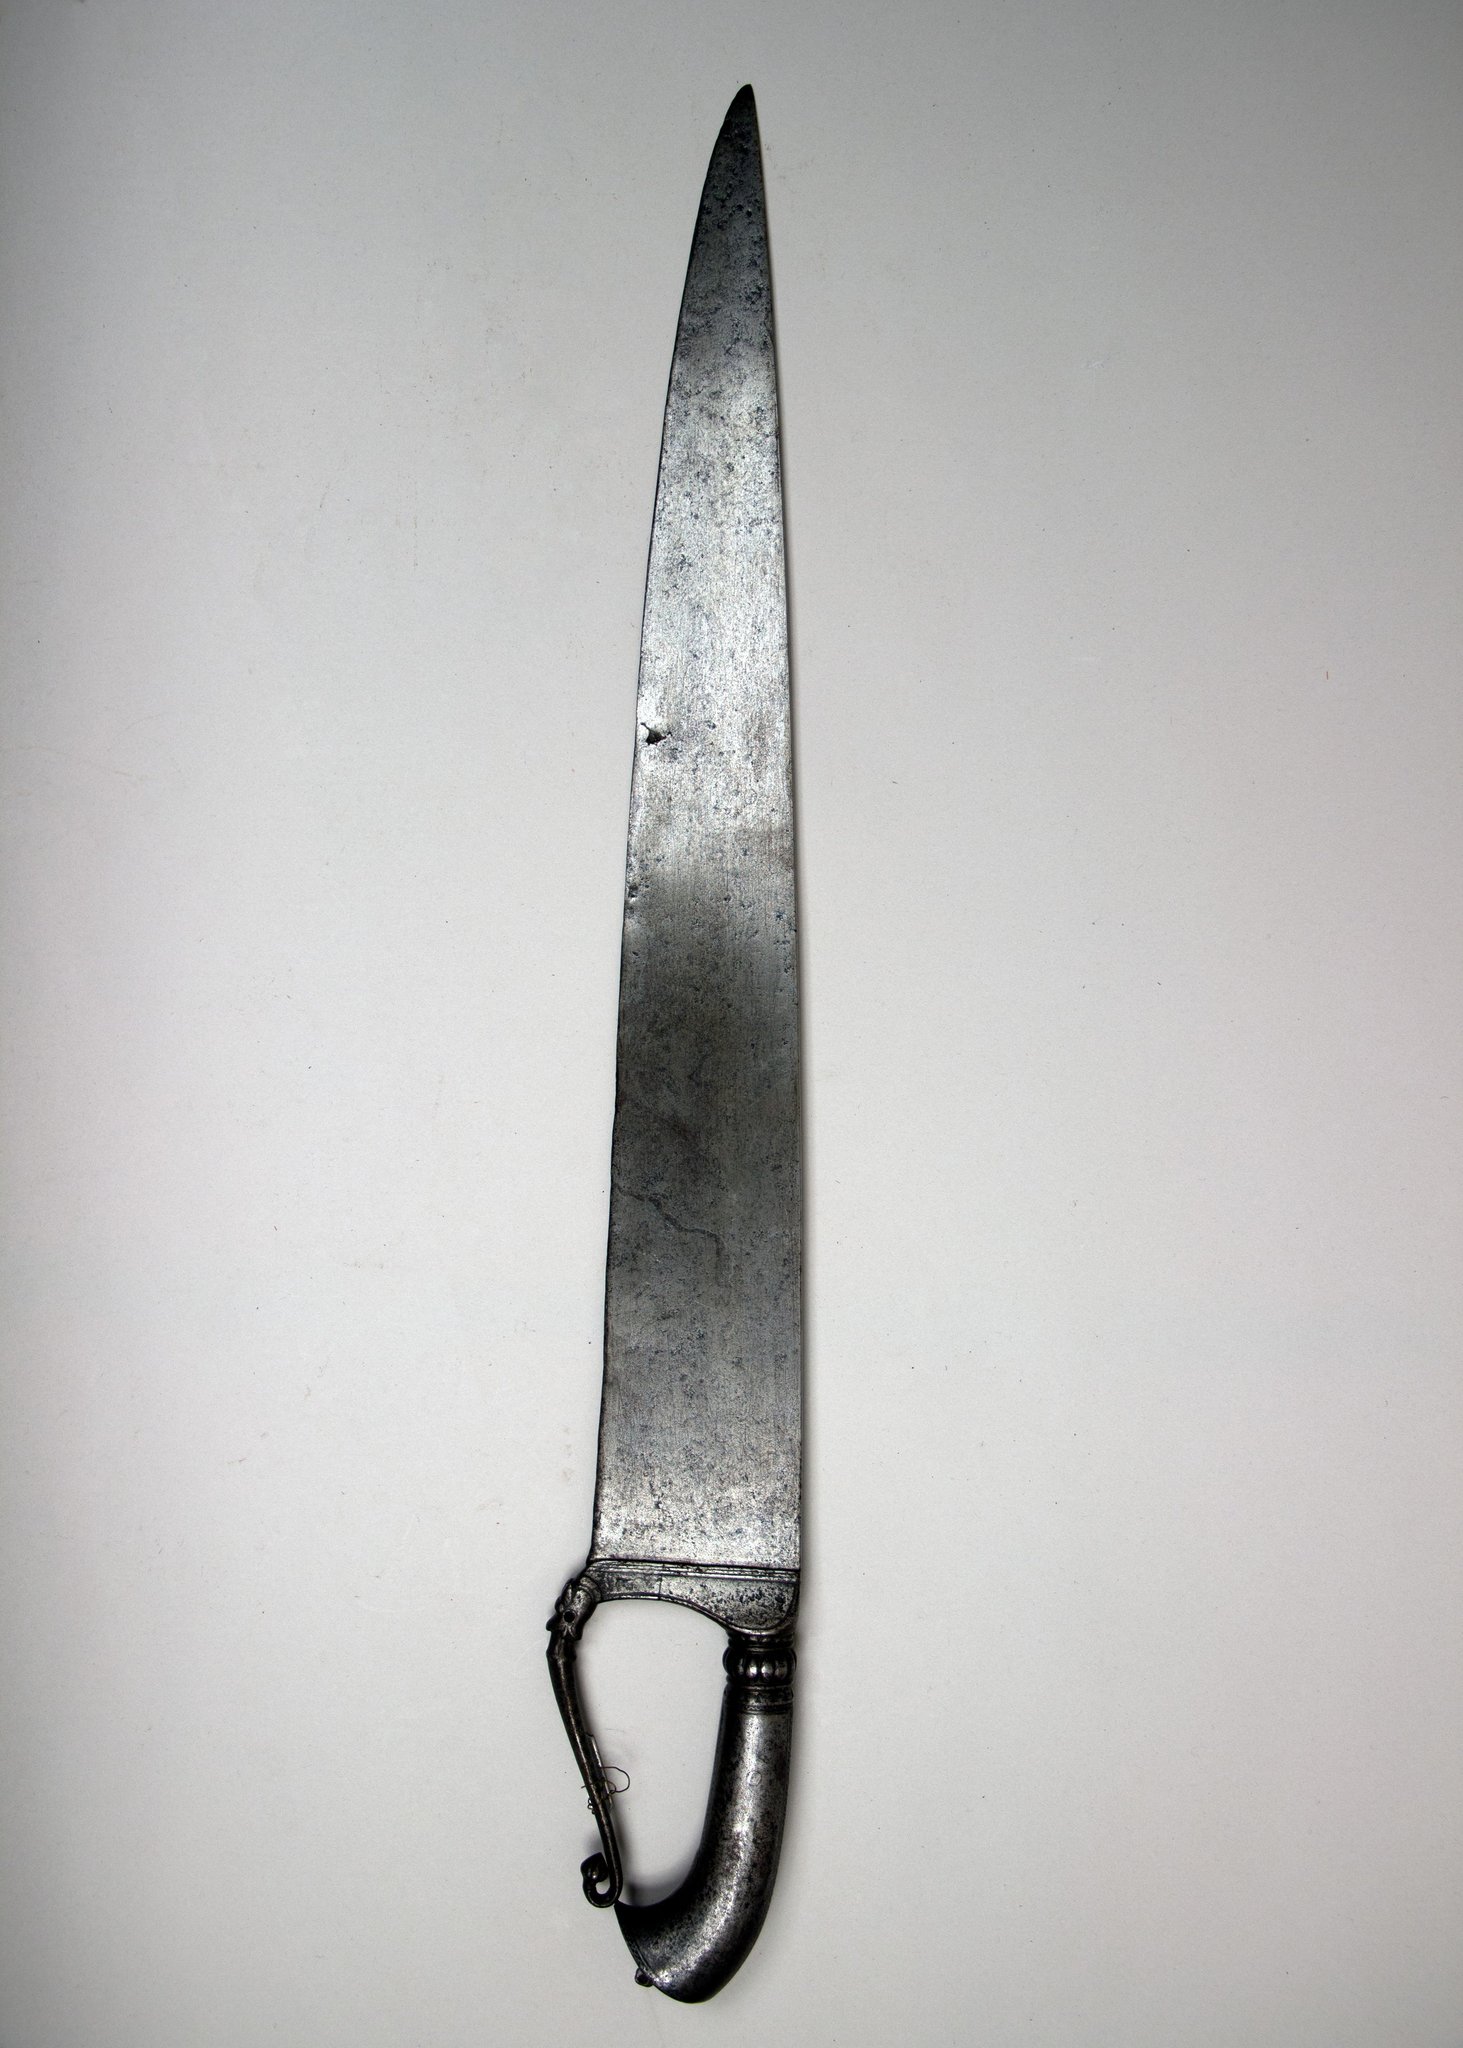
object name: khyber knife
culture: afghan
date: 1701-1900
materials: iron, steel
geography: afghanistan